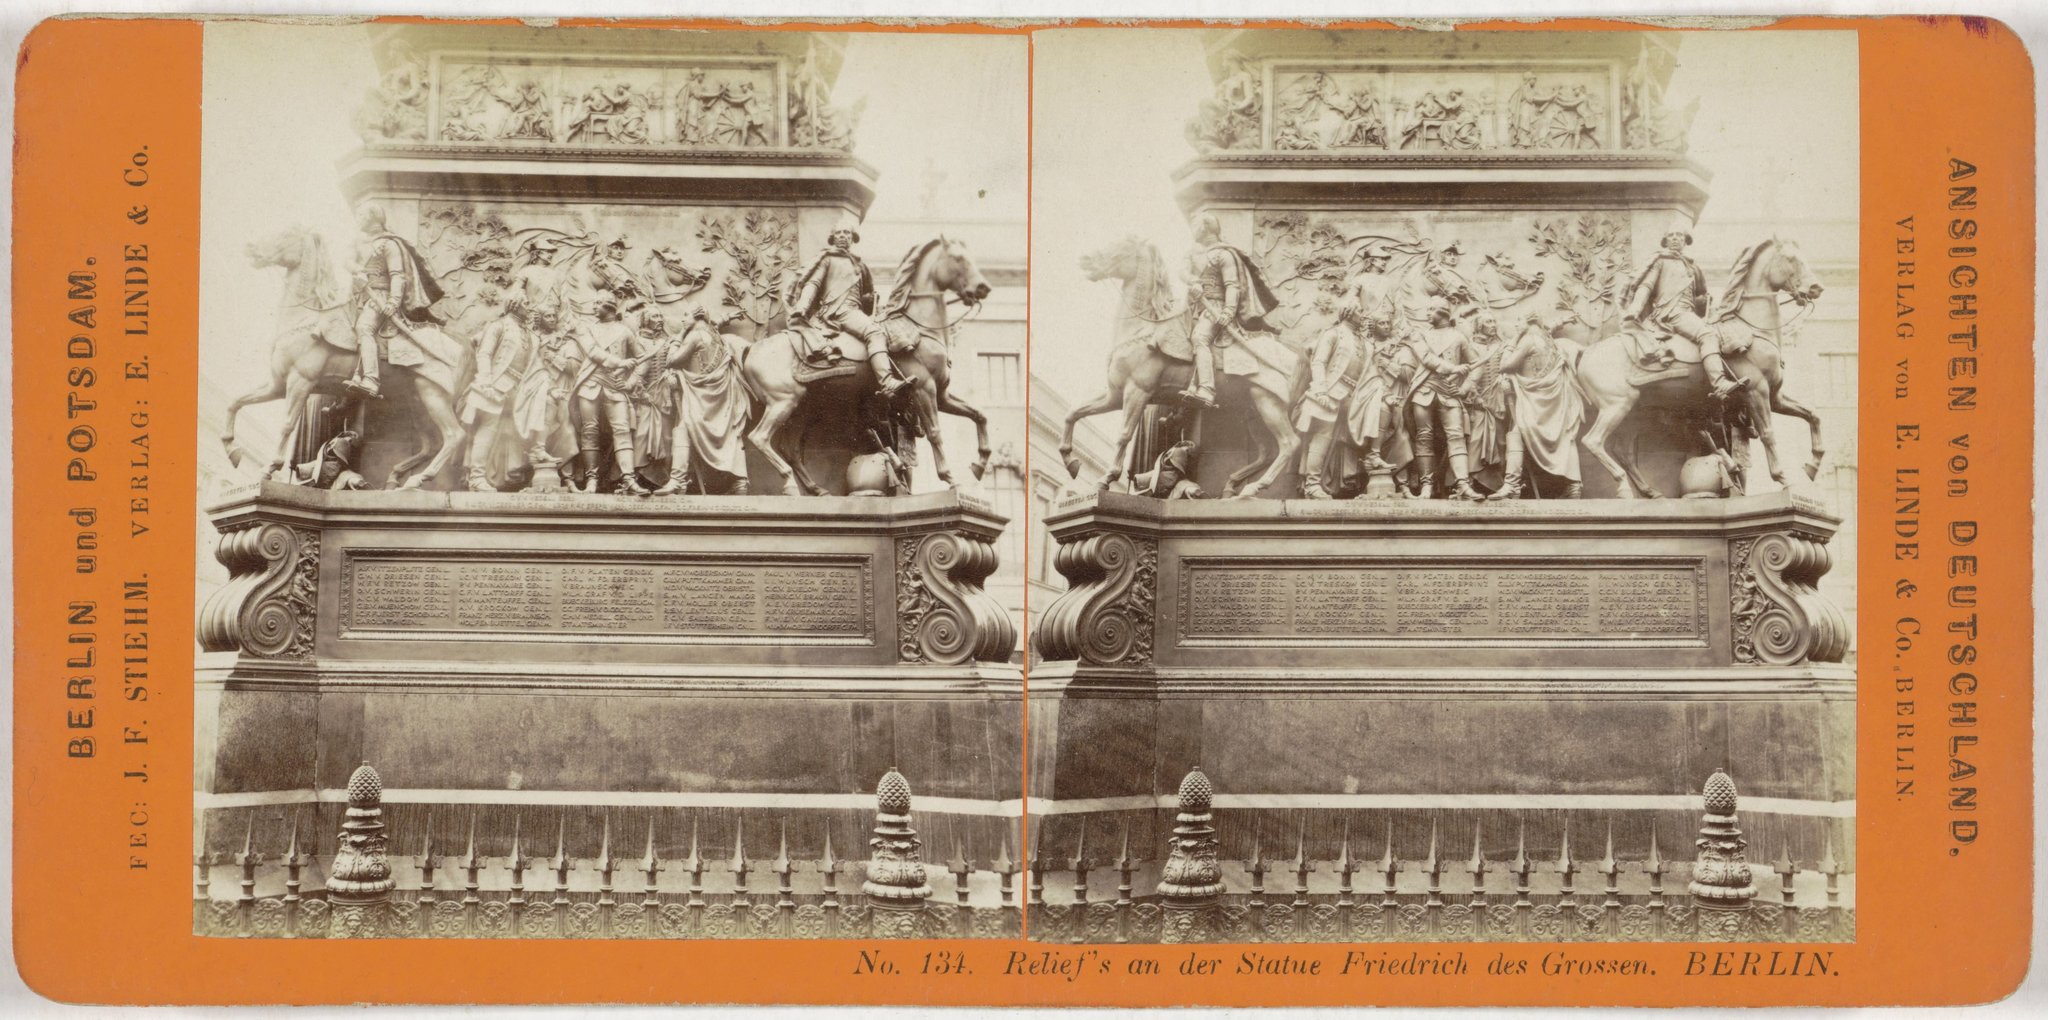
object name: stereograph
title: Relief's an der Statue Friedrich des Grossen. Berlin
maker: johann friedrich stiehm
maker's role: fotograaf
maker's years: 1826-1902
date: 1868-1870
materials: cardboard, paper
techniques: albumen print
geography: berlin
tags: berlin, frederick ii (king of prussia), pedestal of a piece of sculpture (perhaps in the form of a herm)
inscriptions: number: ‘No. 134.’